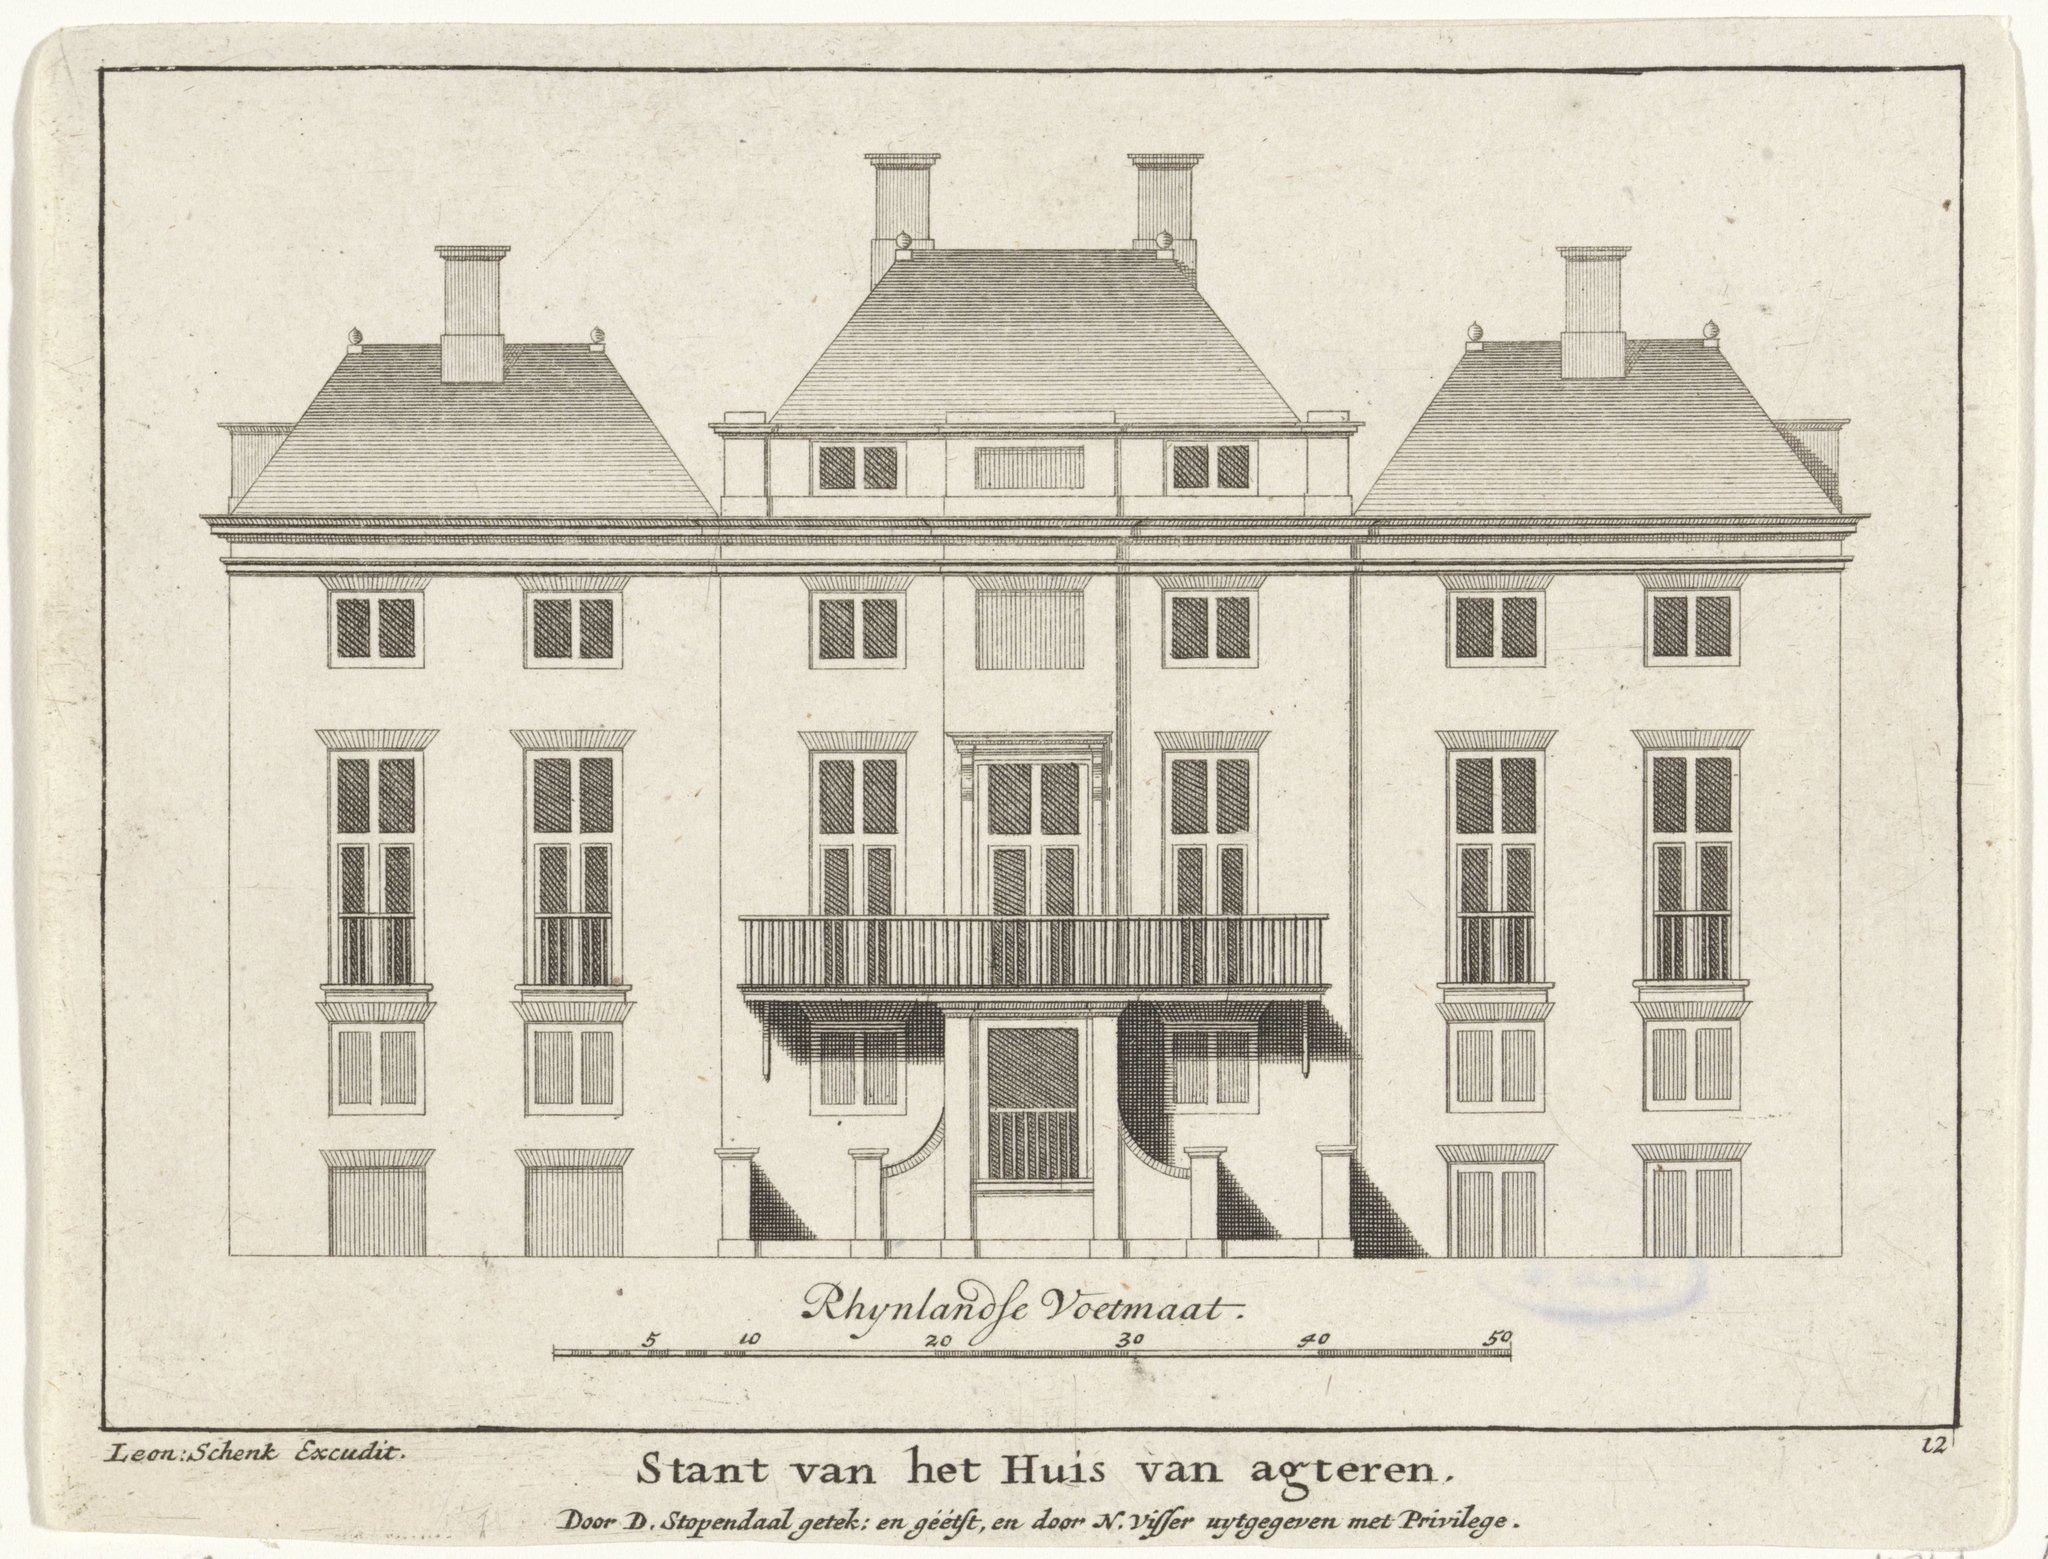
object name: print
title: Stant van het Huis van agteren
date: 1682-1726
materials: paper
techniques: etching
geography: amsterdam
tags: exterior ~ architectural design or model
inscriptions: collector's mark: Lugt 2228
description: De achtergevel van Huis Clingendael te Den Haag. Onderaan een schaalverdeling.